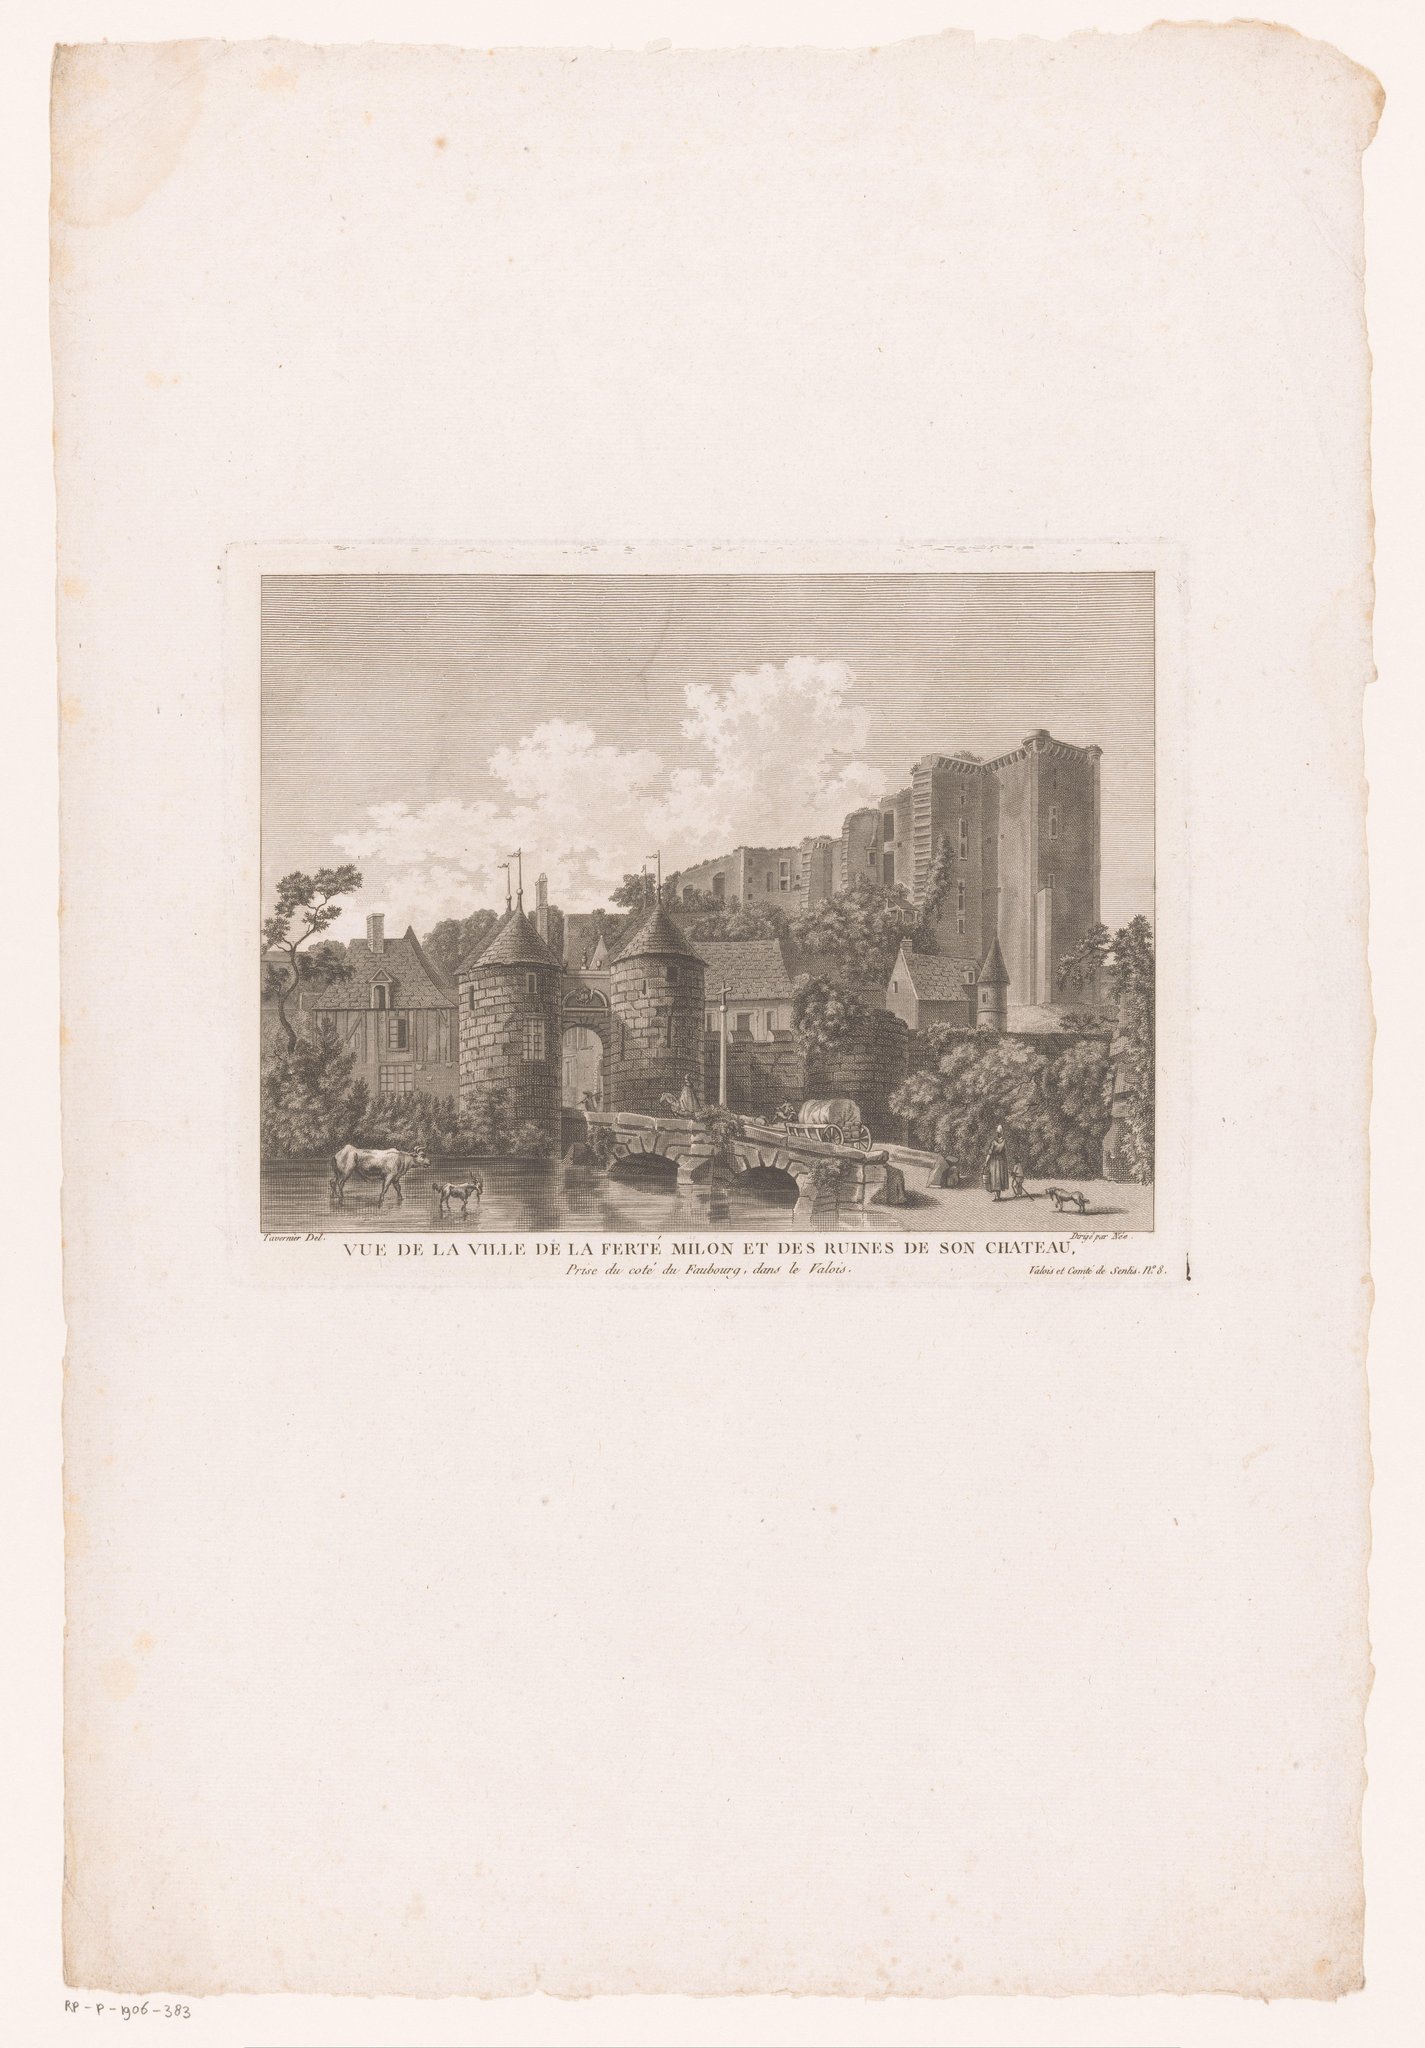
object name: print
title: Vue de la ville de la Ferté Milon et des ruines de son chateau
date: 1749-1817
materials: paper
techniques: etching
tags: city-view in general; 'veduta', city-gate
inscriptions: collector's mark: Lugt 2228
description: Genummerd rechtsonder: Valois et Comté de Senlis. No. 8.